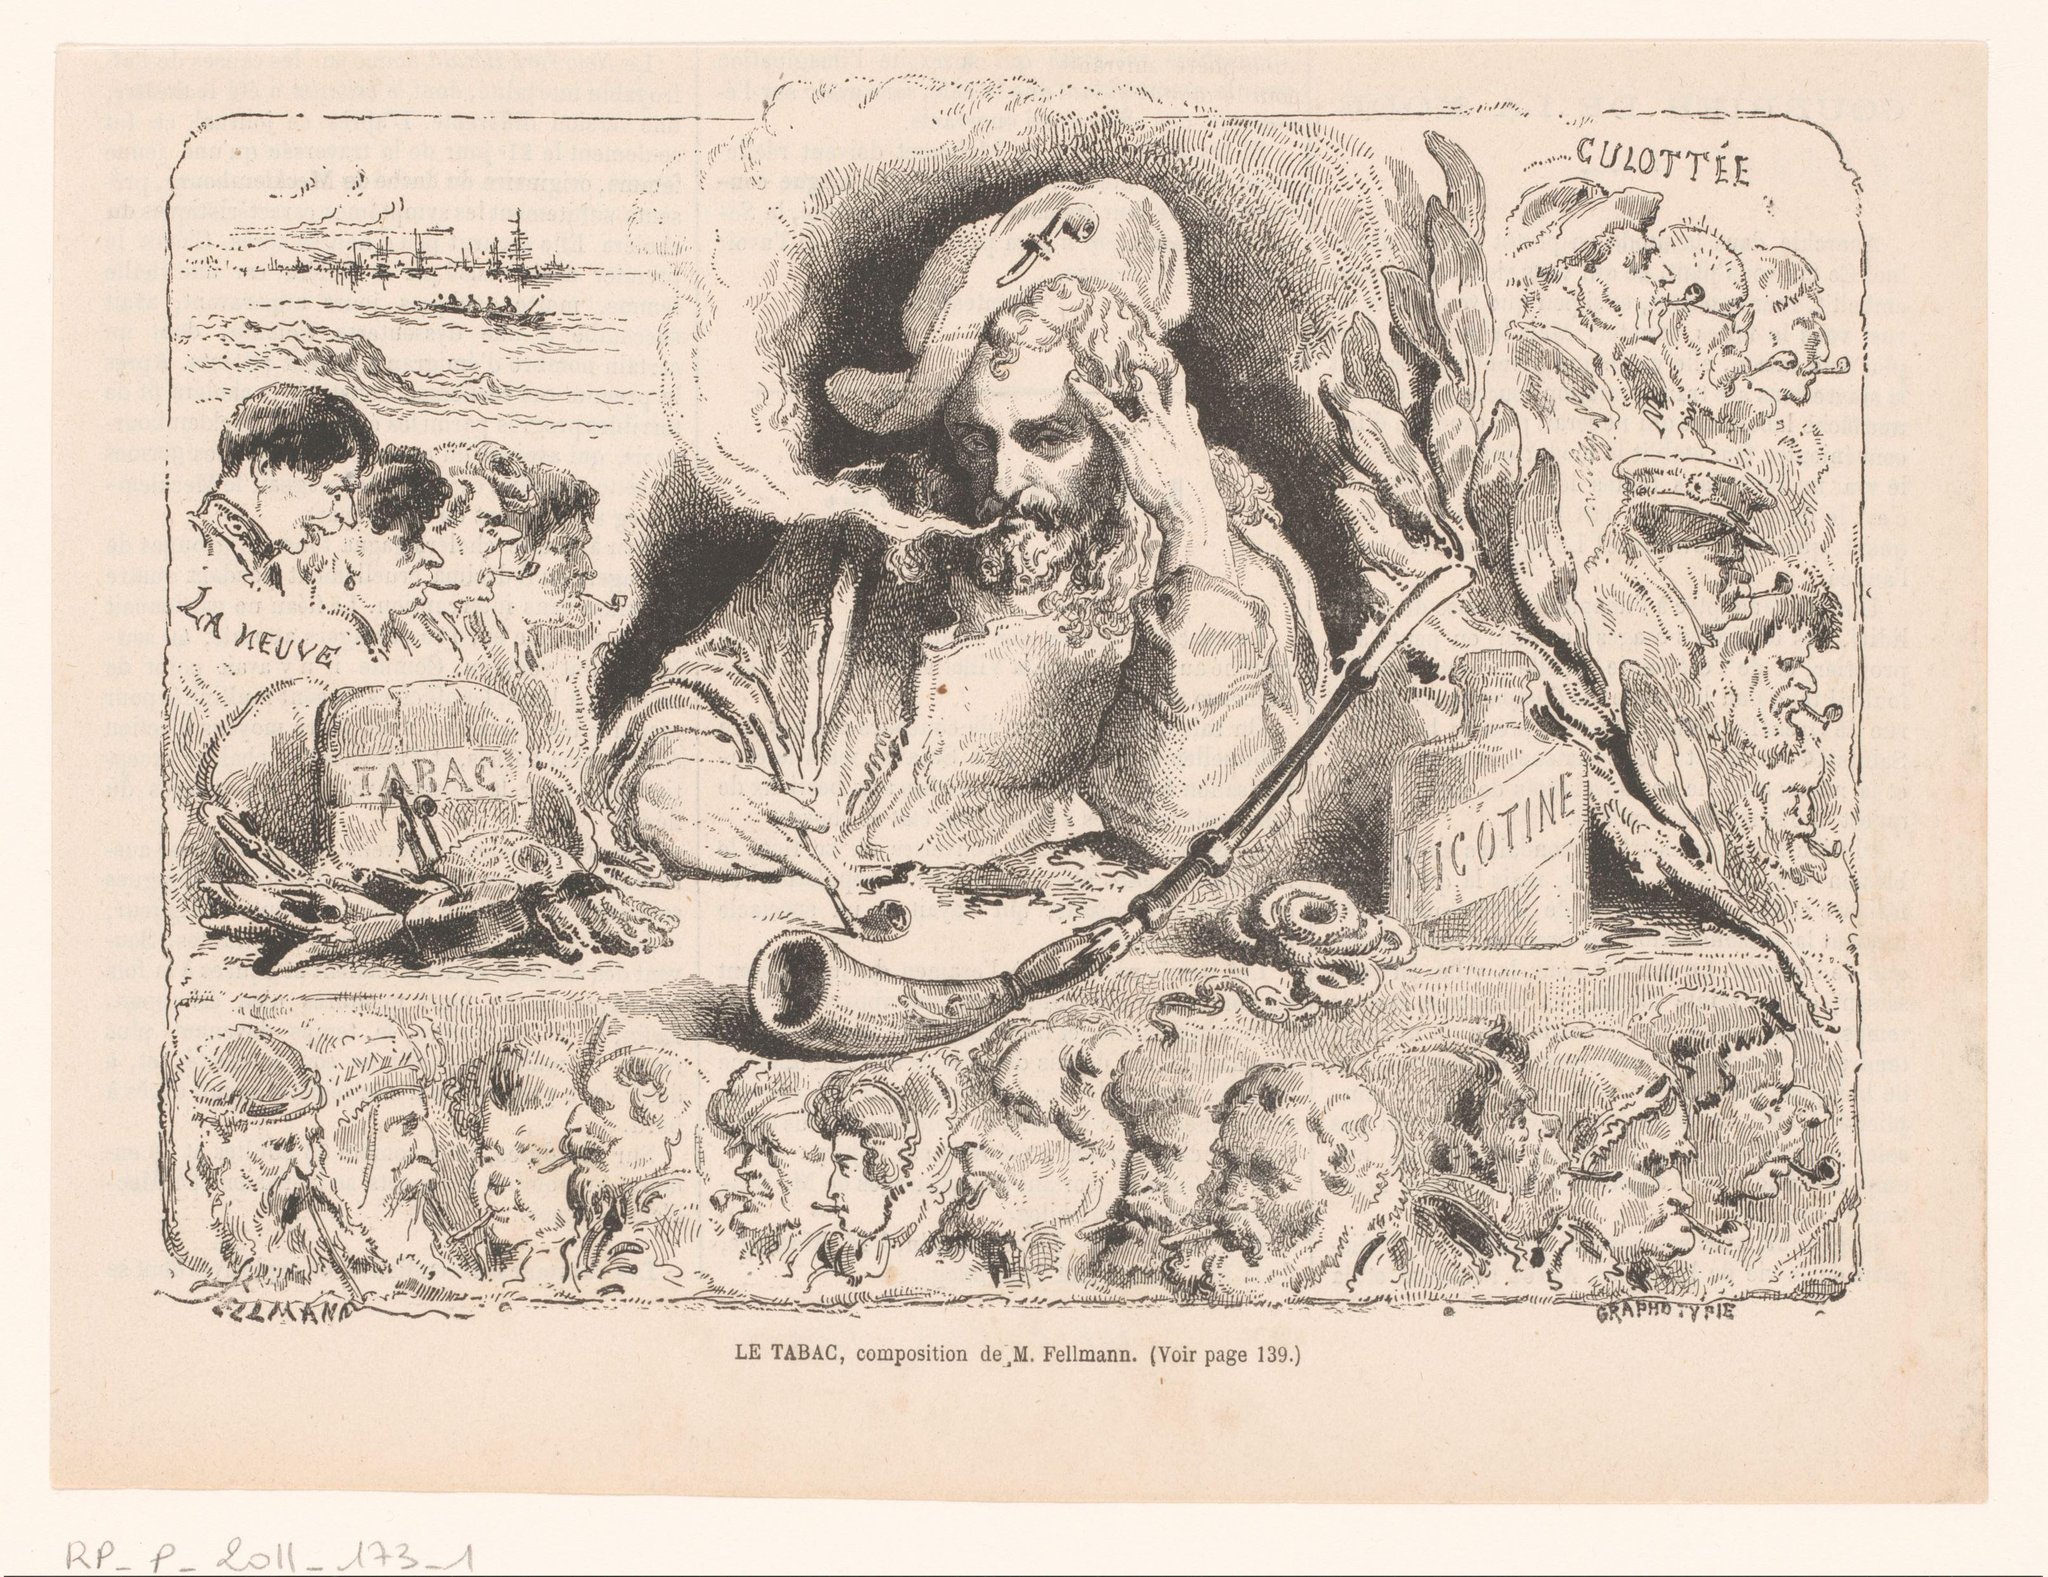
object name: print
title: Jakobus de Meerdere in een allegorie op tabak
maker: m. fellmann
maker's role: print maker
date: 1800-1900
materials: paper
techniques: graphotype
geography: france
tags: the apostle james the great; possible attributes: book, pilgrim's cloak, hat, shell, staff, and wallet, scroll, sword (+ variant), tobacco (+ variant), pipe ~ tobacco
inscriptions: collector's mark: Lugt 2228, collector's mark: Lugt 2760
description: Na de overname van de firma Niemeyer door British American Tabacco Group besloot deze de collectie van het Niemeyer Tabaksmuseum af te stoten. De beheerder van de collectie, het Noordelijk Scheepvaartmuseum, organiseerde in januari 2011 open dagen voor musea waar deze hun voorkeuren voor collectieonderdelen kenbaar konden maken. De objecten zijn getaxeerd door medewerkers van Christie's en vervolgens ter overname aangeboden aan de belangstellende musea. Het Rijksprentenkabinet koos 46 prenten uit de collectie tegen door de medewerkers van Christie's vastgestelde waarde. [H. Leeflang, 2011-06-09]